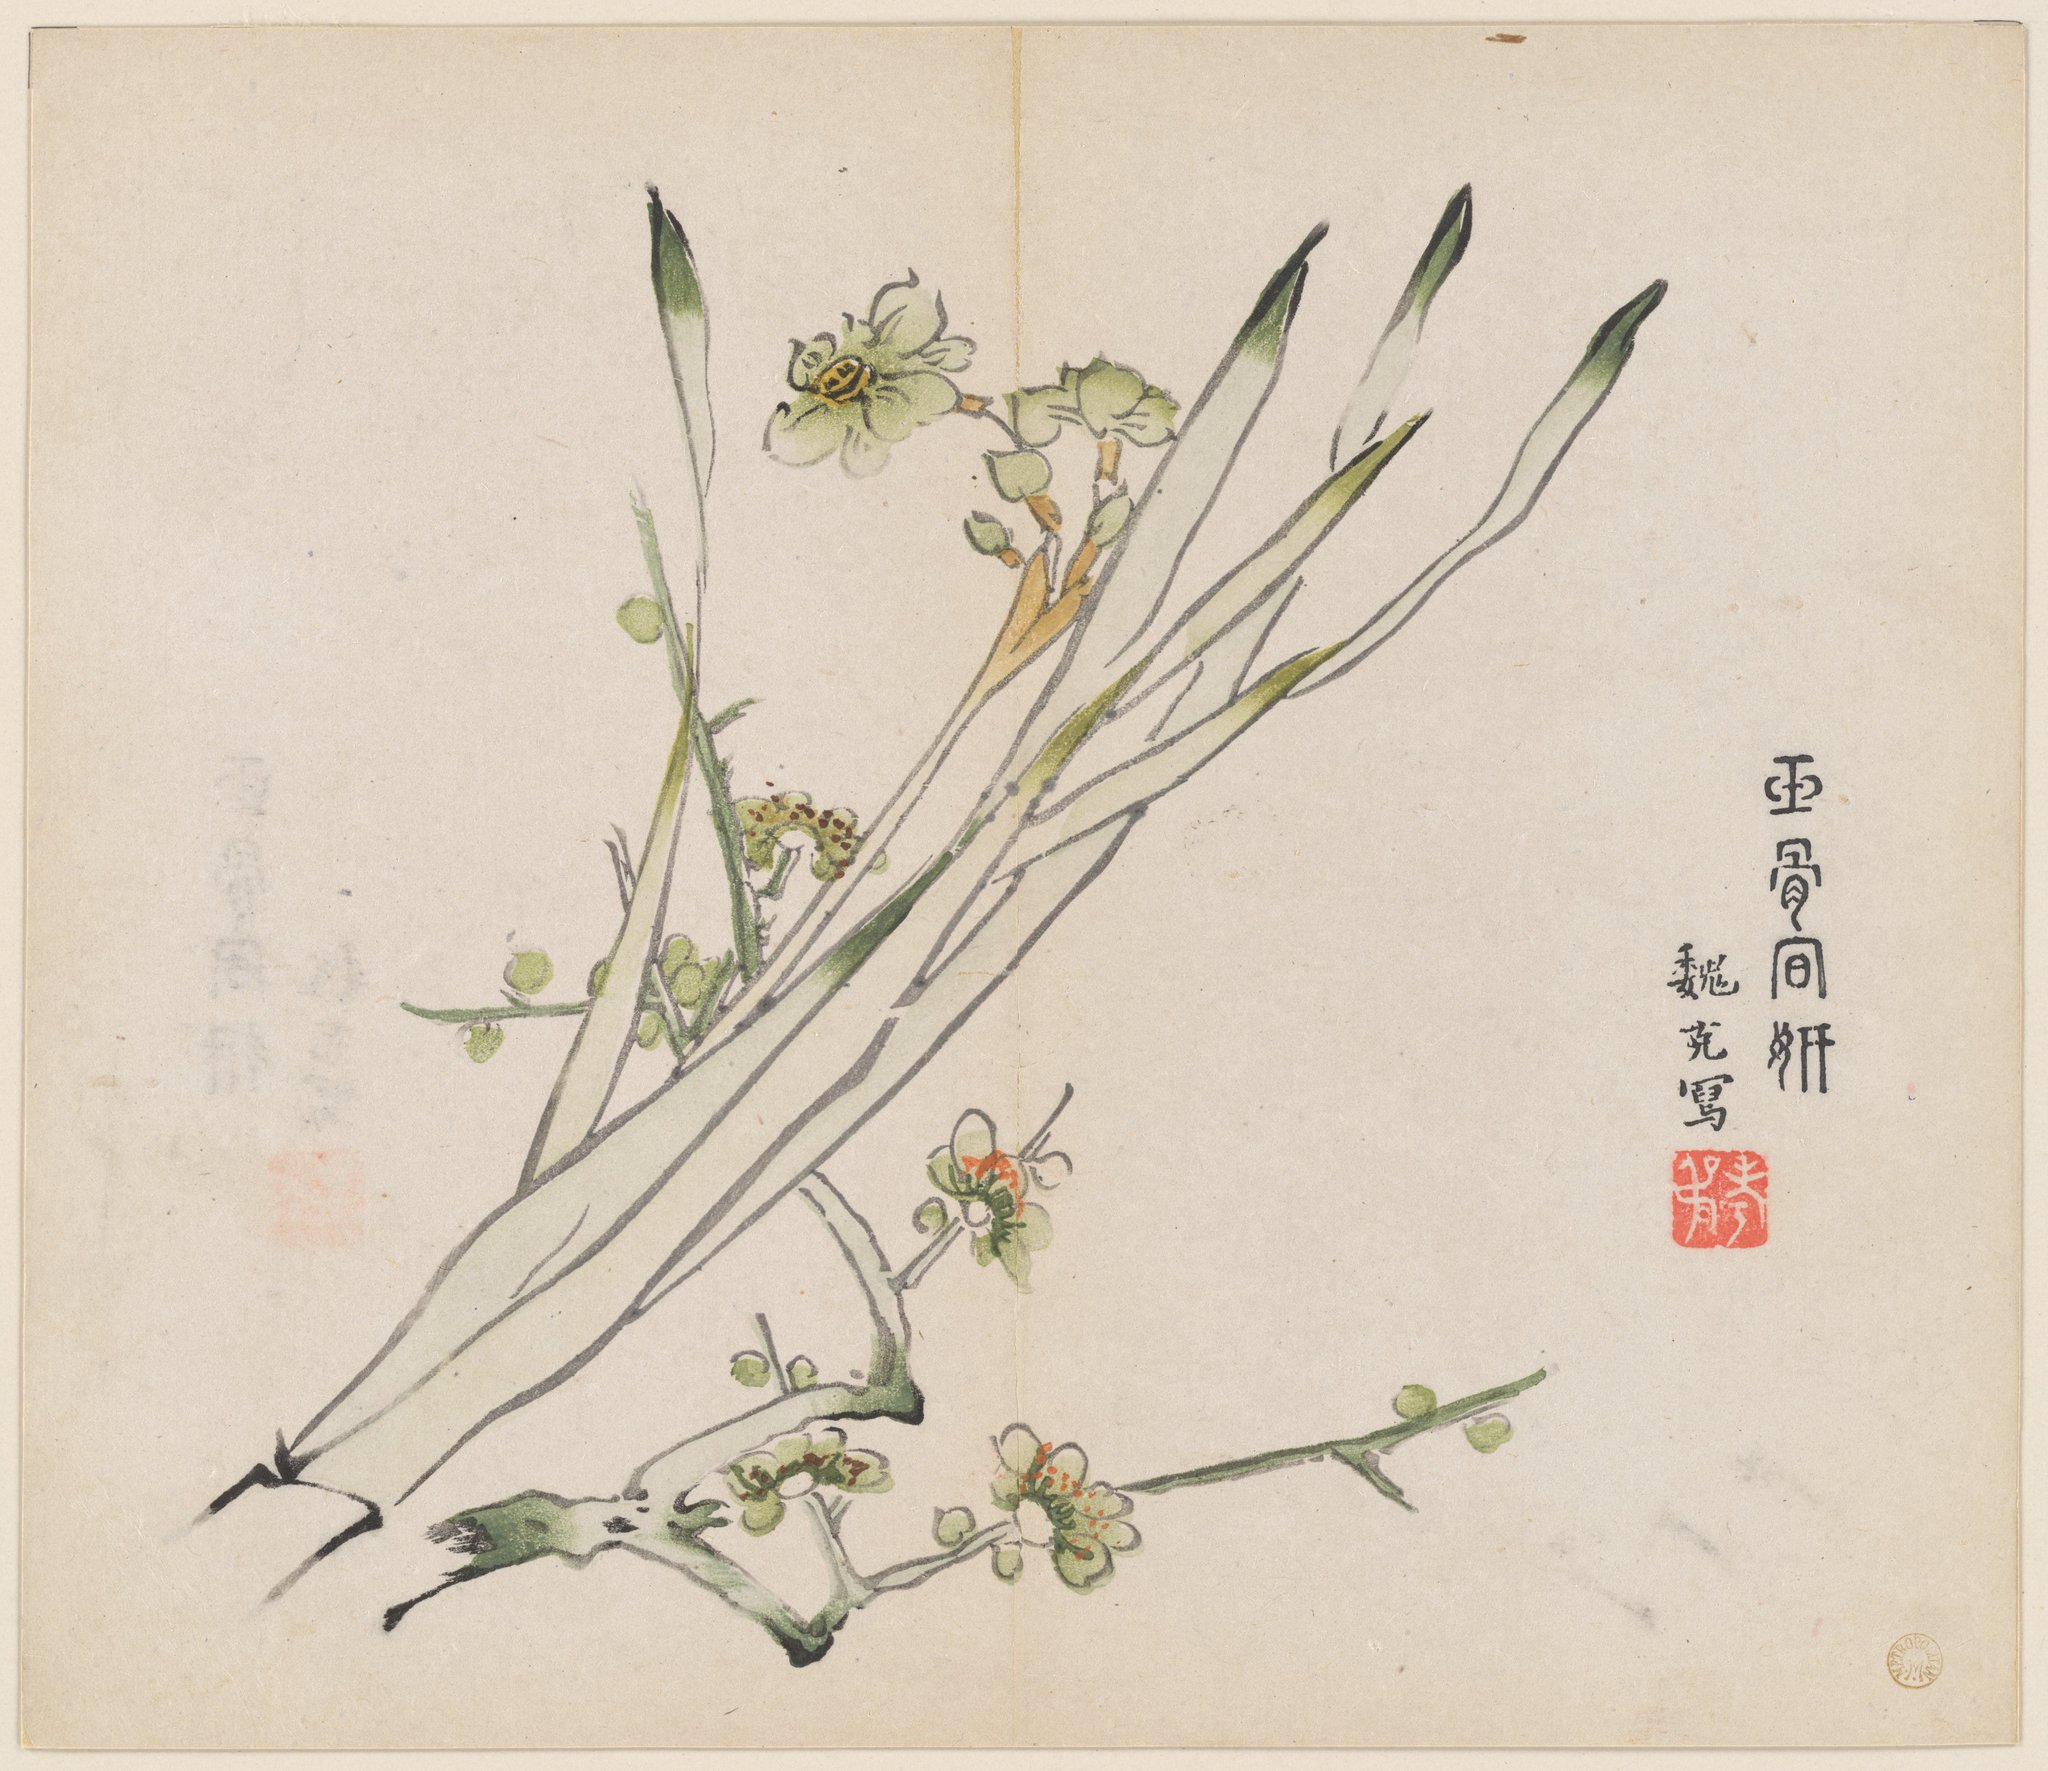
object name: print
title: Page from the Ten Bamboo Studio Manual of Painting and Calligraphy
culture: chinese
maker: hu zhengyan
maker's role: artist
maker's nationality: chinese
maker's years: 1584-1634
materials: ink, paper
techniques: printing